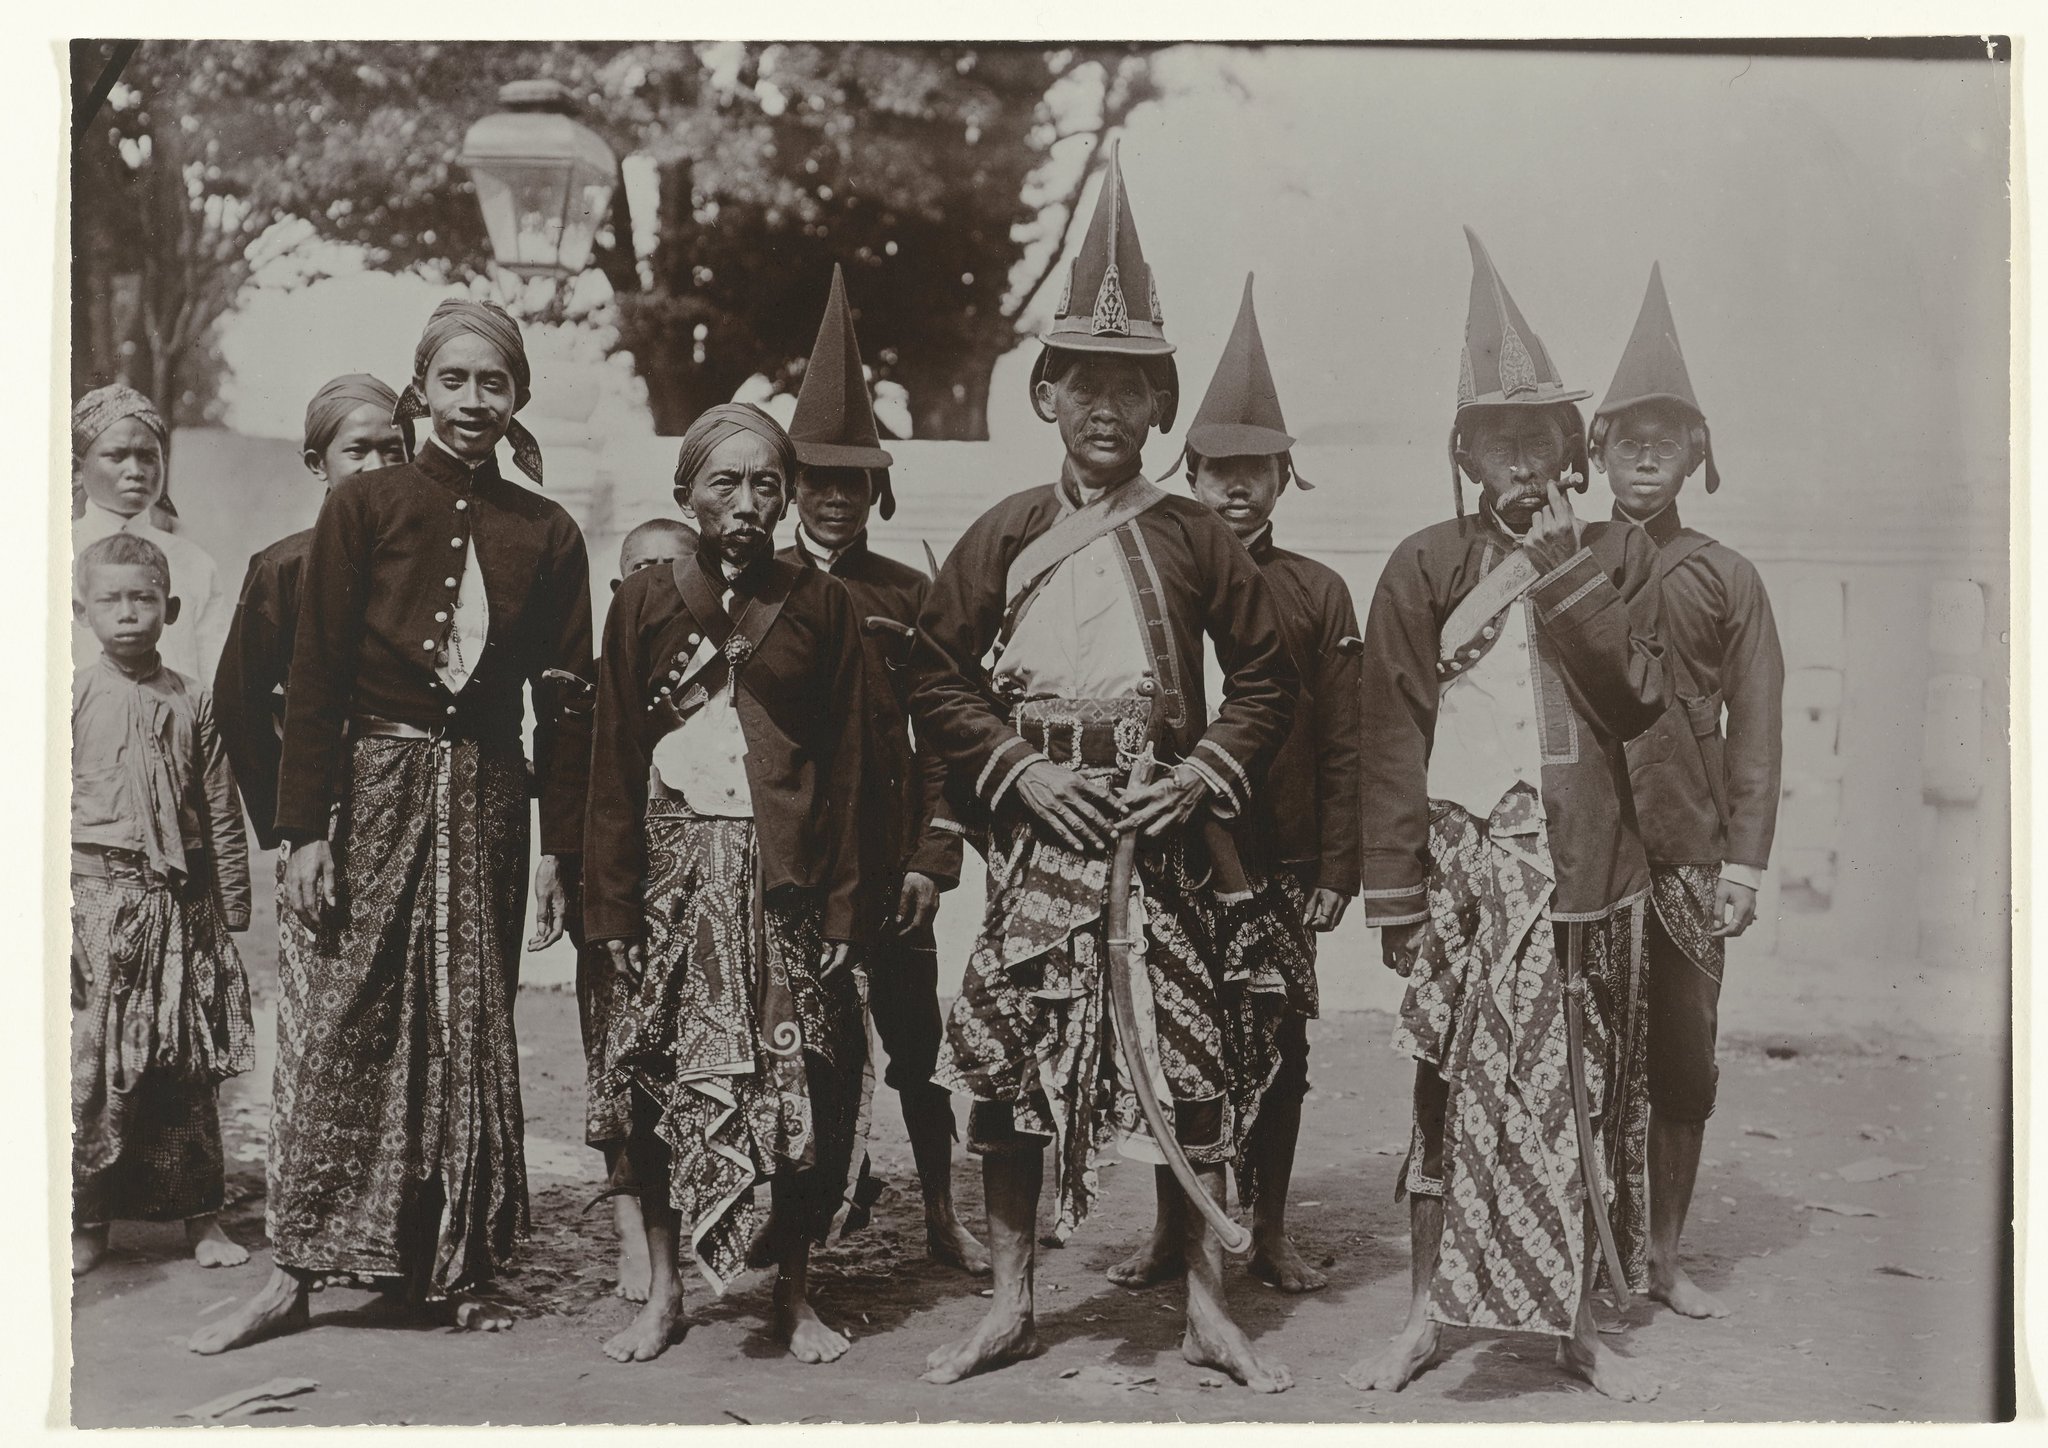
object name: photograph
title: Javaanse mannen in uniform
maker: kassian céphas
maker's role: fotograaf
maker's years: 1845-1912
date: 1867-1910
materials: cardboard, paper, photographic support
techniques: albumen print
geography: java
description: Javaanse mannen in uniform, dragen een sarong en lopend op blote voeten. Boven de sarong een open jasje met ronde kraag. Een aantal mannen draagt een puntvormig hoofddeksel en een zwaard. De andere mannen dragen een iket.